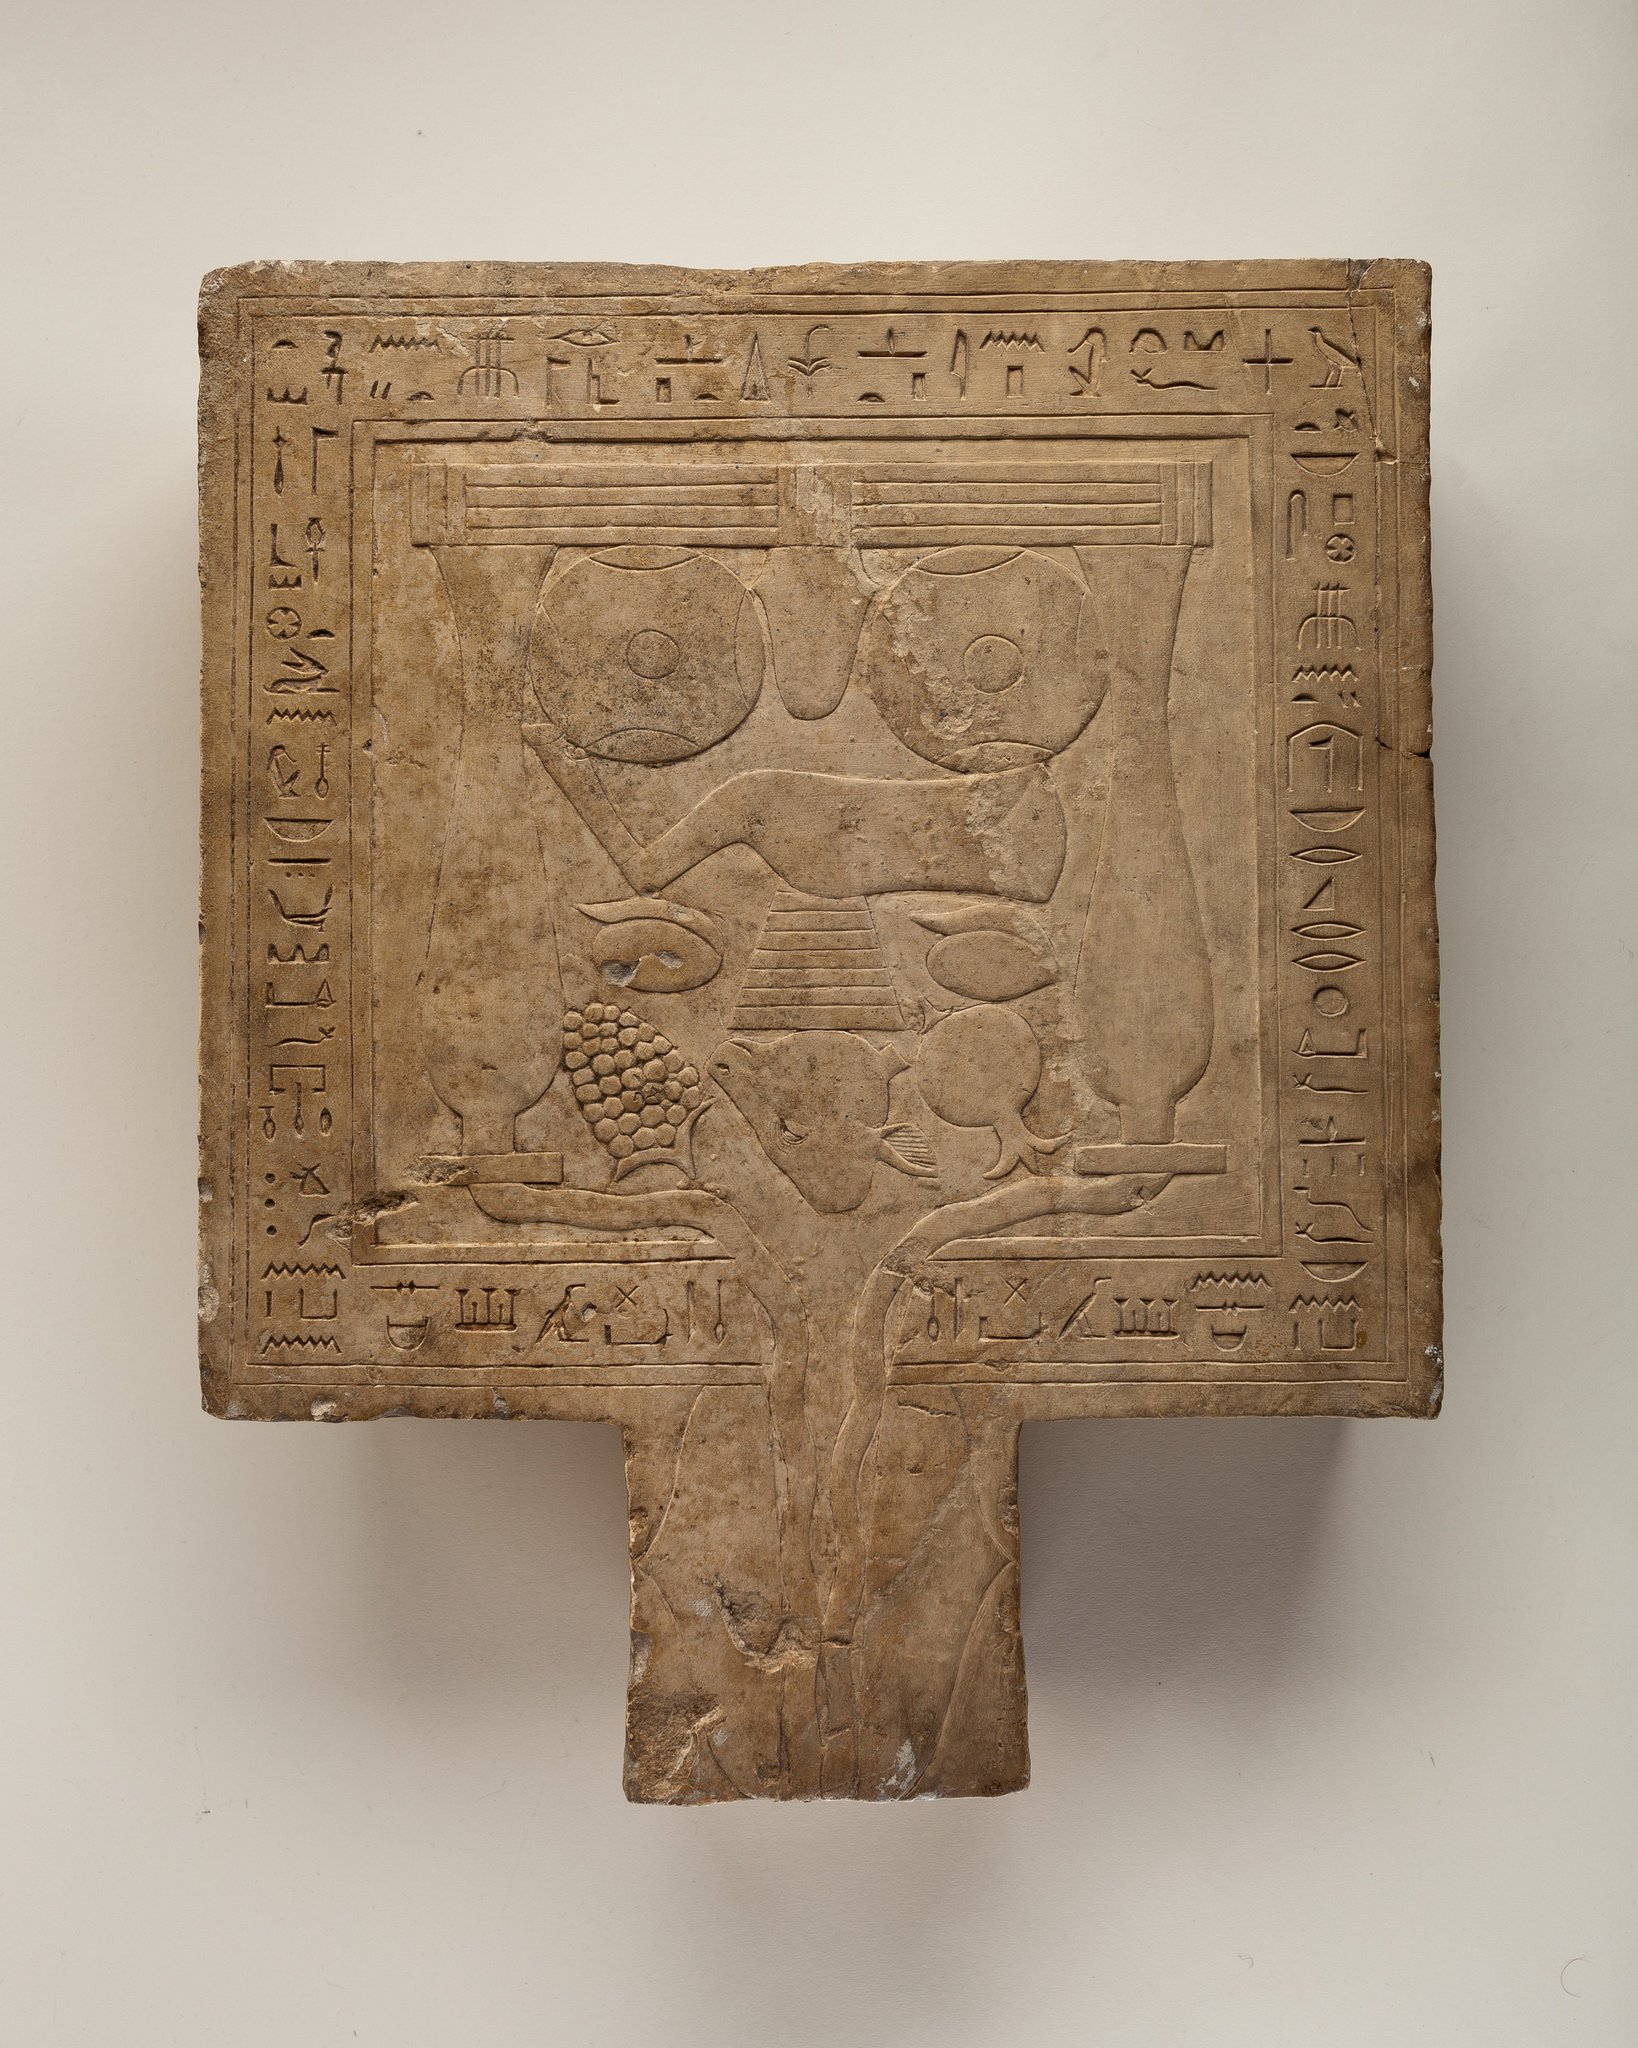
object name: offering table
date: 664-332 BCE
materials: limestone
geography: egypt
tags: hieroglyphs